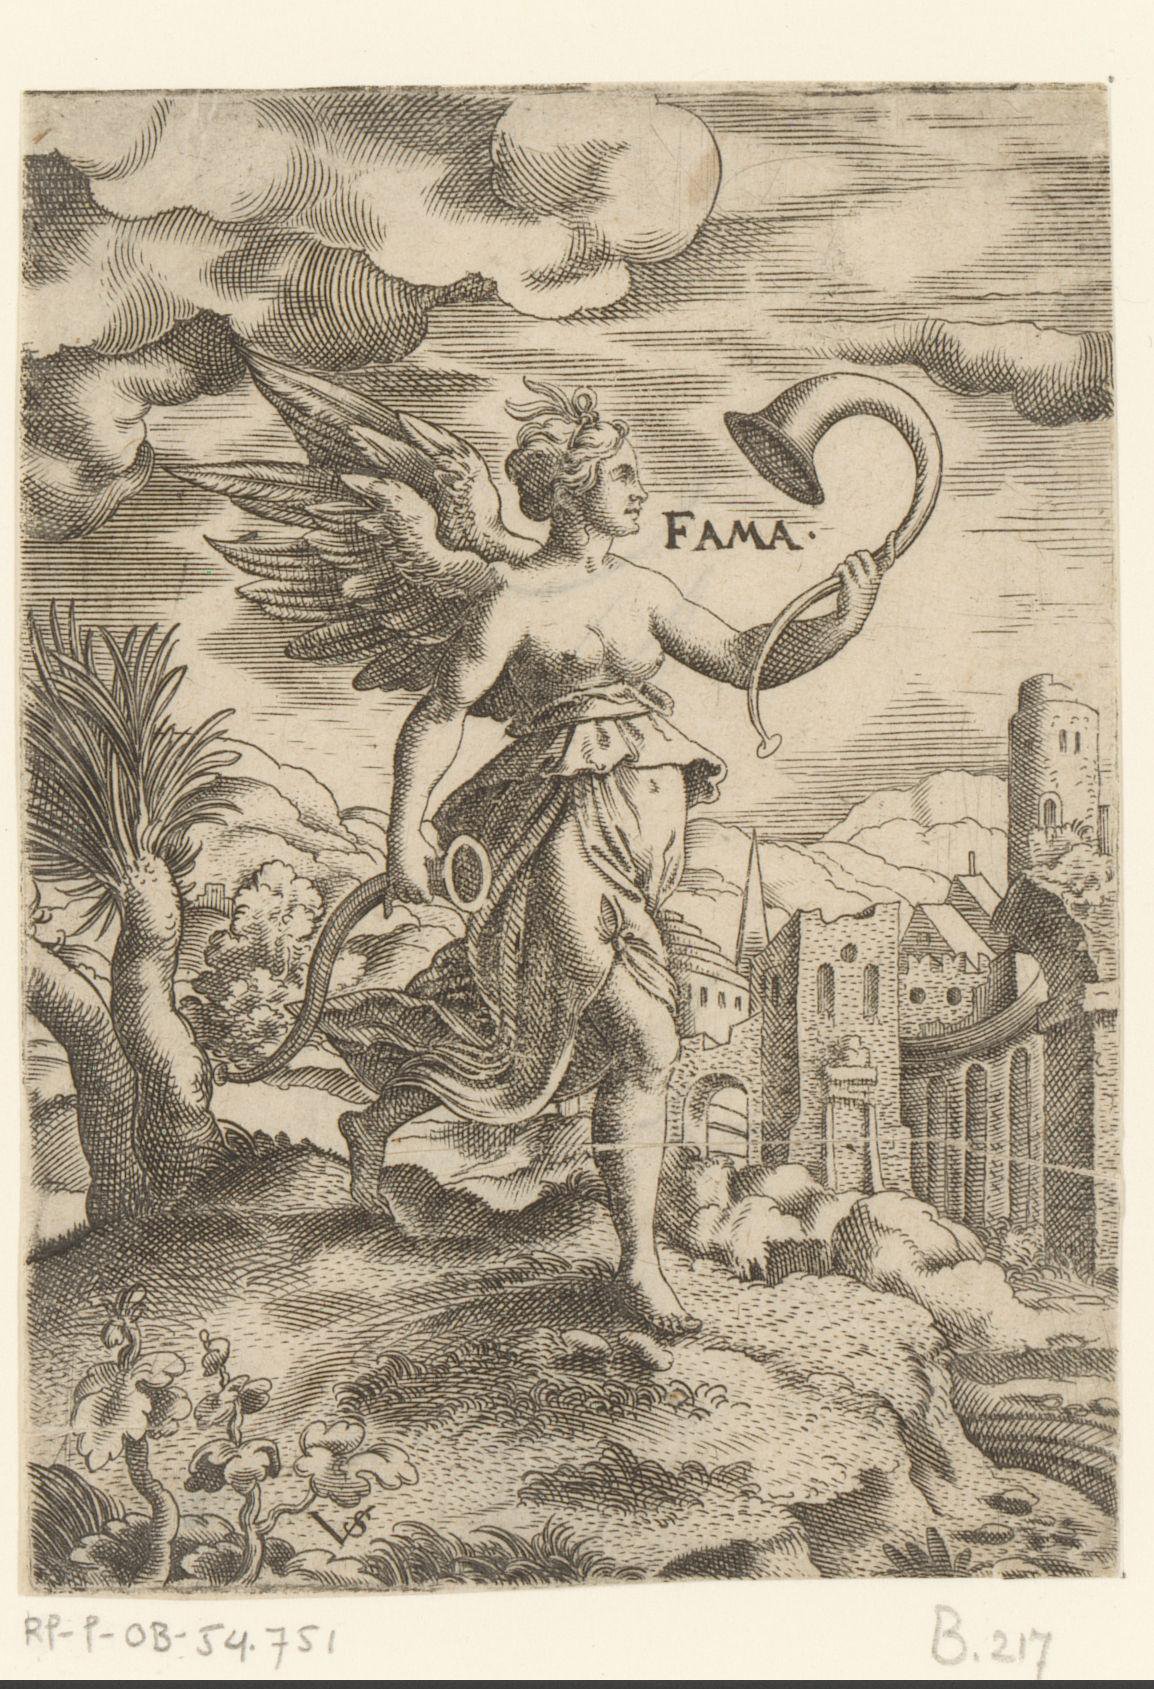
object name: print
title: Faam in een landschap met ruïnes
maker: virgilius solis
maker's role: draughtsman, print maker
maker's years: 1514-1562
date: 1524-1562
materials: paper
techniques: engraving, etching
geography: nuremberg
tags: landscape with ruins, fama as roman personification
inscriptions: number: ‘117’, collector's mark: Lugt 2228